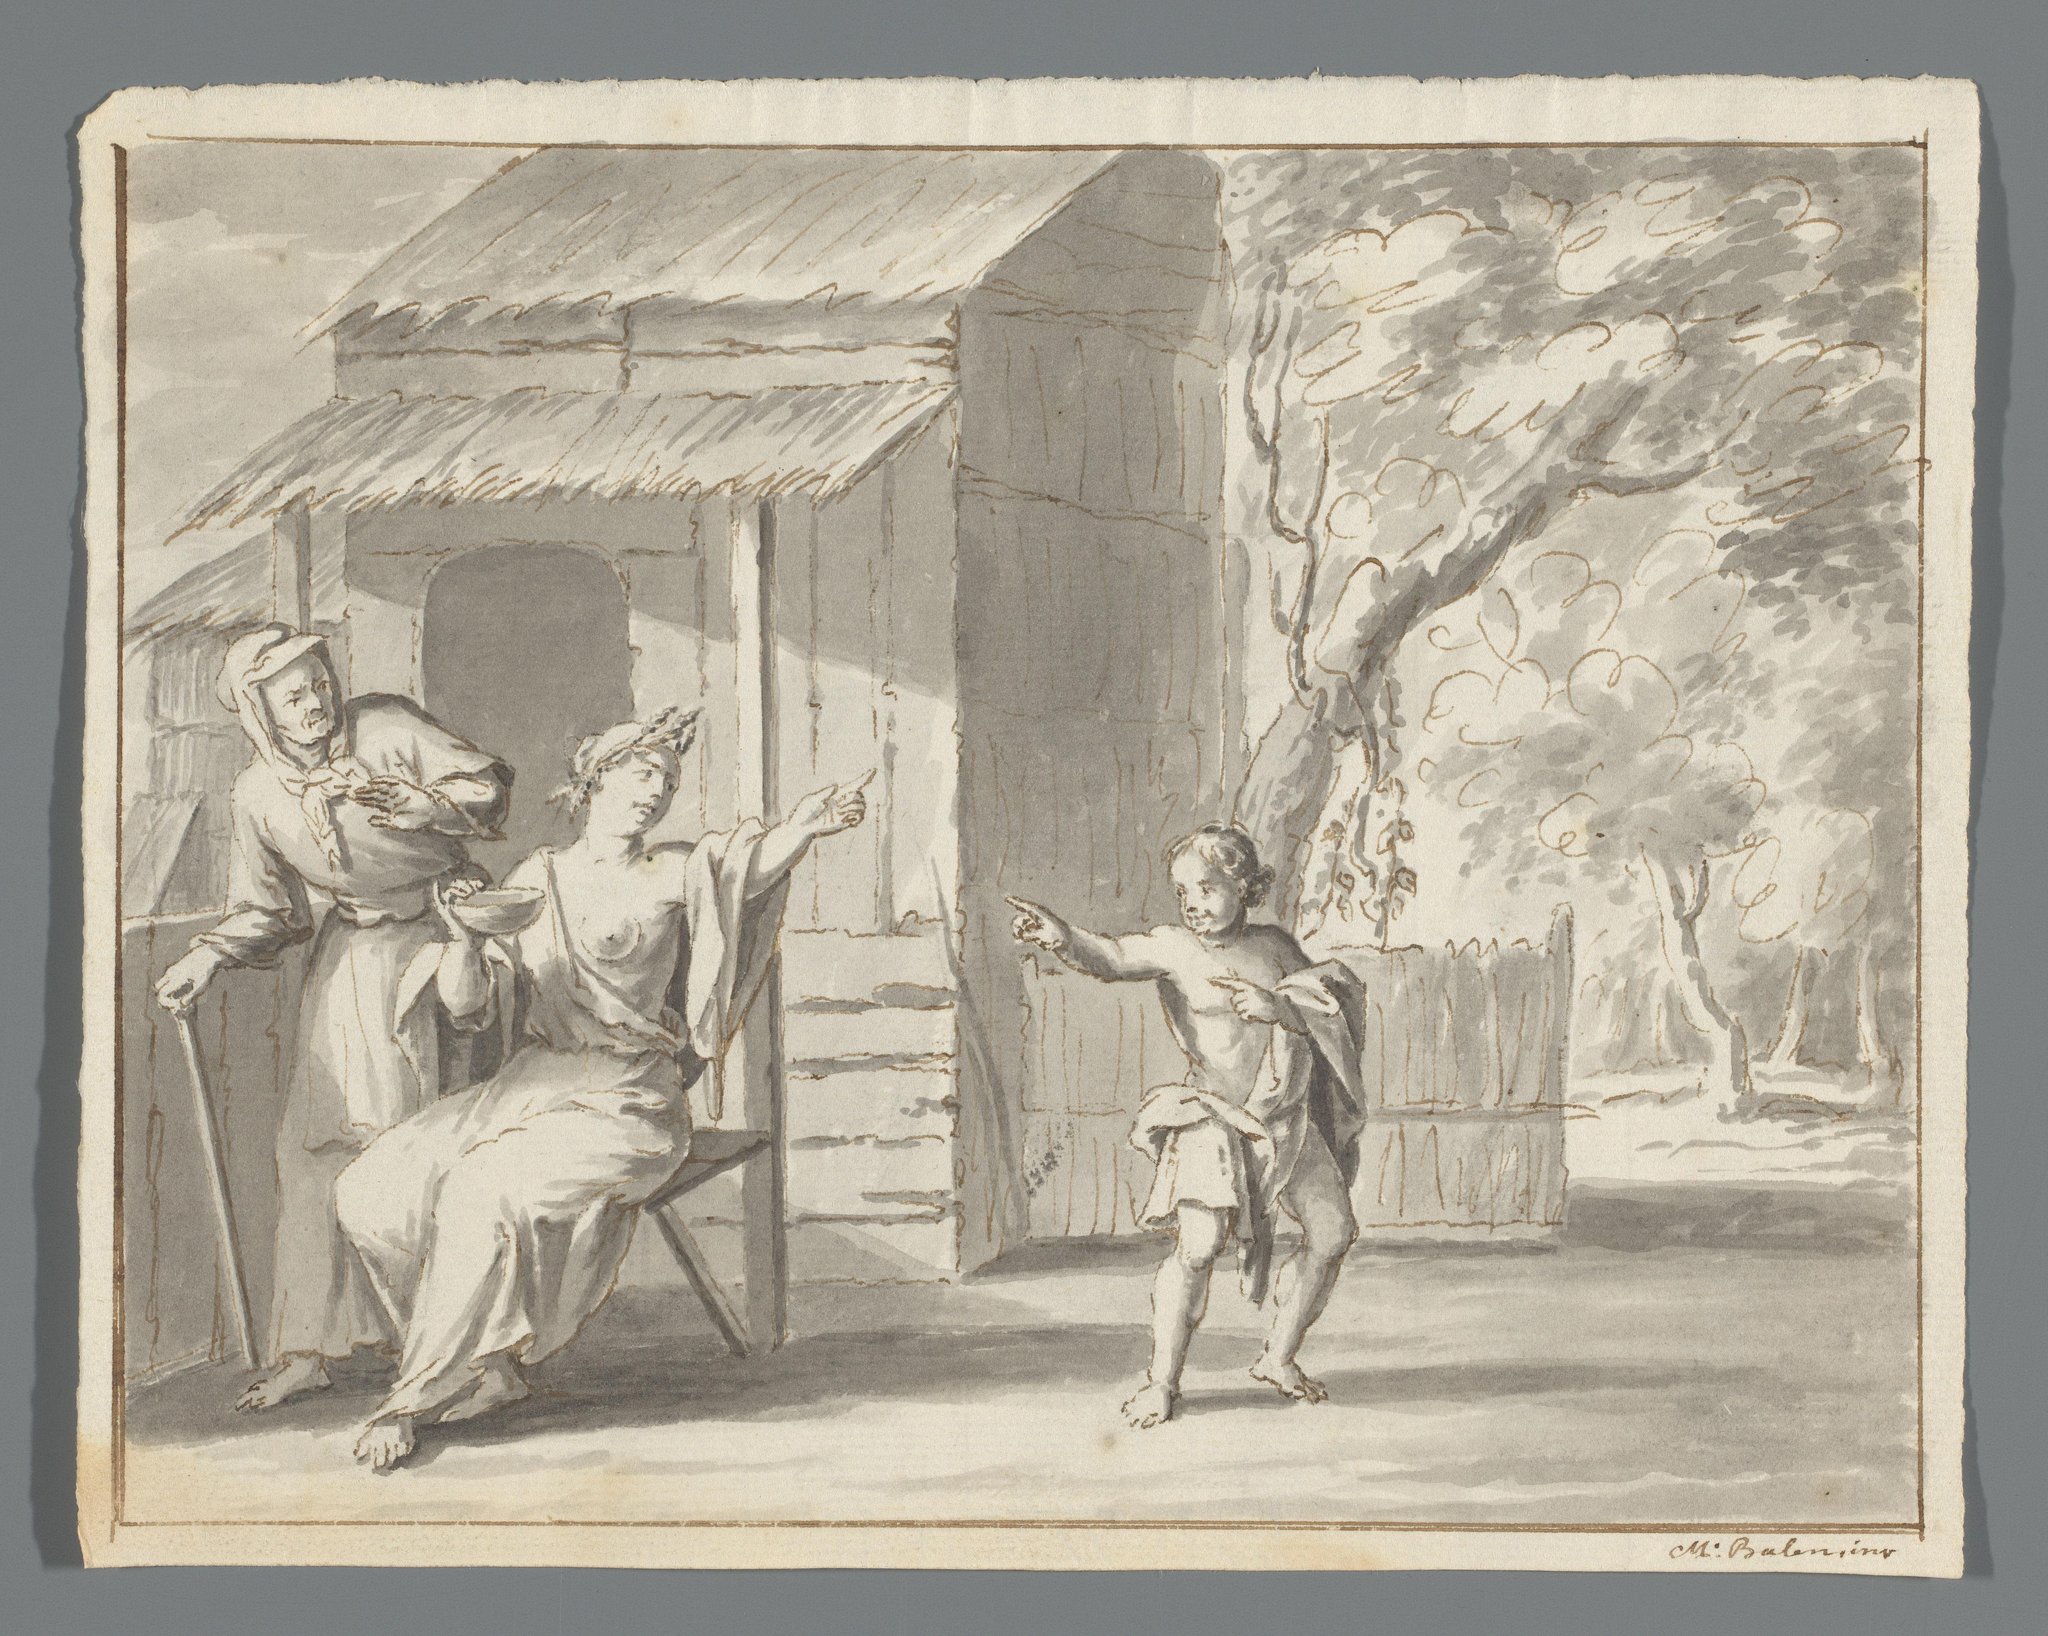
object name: drawing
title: Bespotting van Ceres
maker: matthijs balen (1684-1766)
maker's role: draughtsman, painter, print maker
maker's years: 1684-1766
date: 1694-1766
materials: paper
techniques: brush, pen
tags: a little boy (abas, ascalabus, or stellio) laughs at ceres, because she drinks too avidly while she is resting at an old woman's house